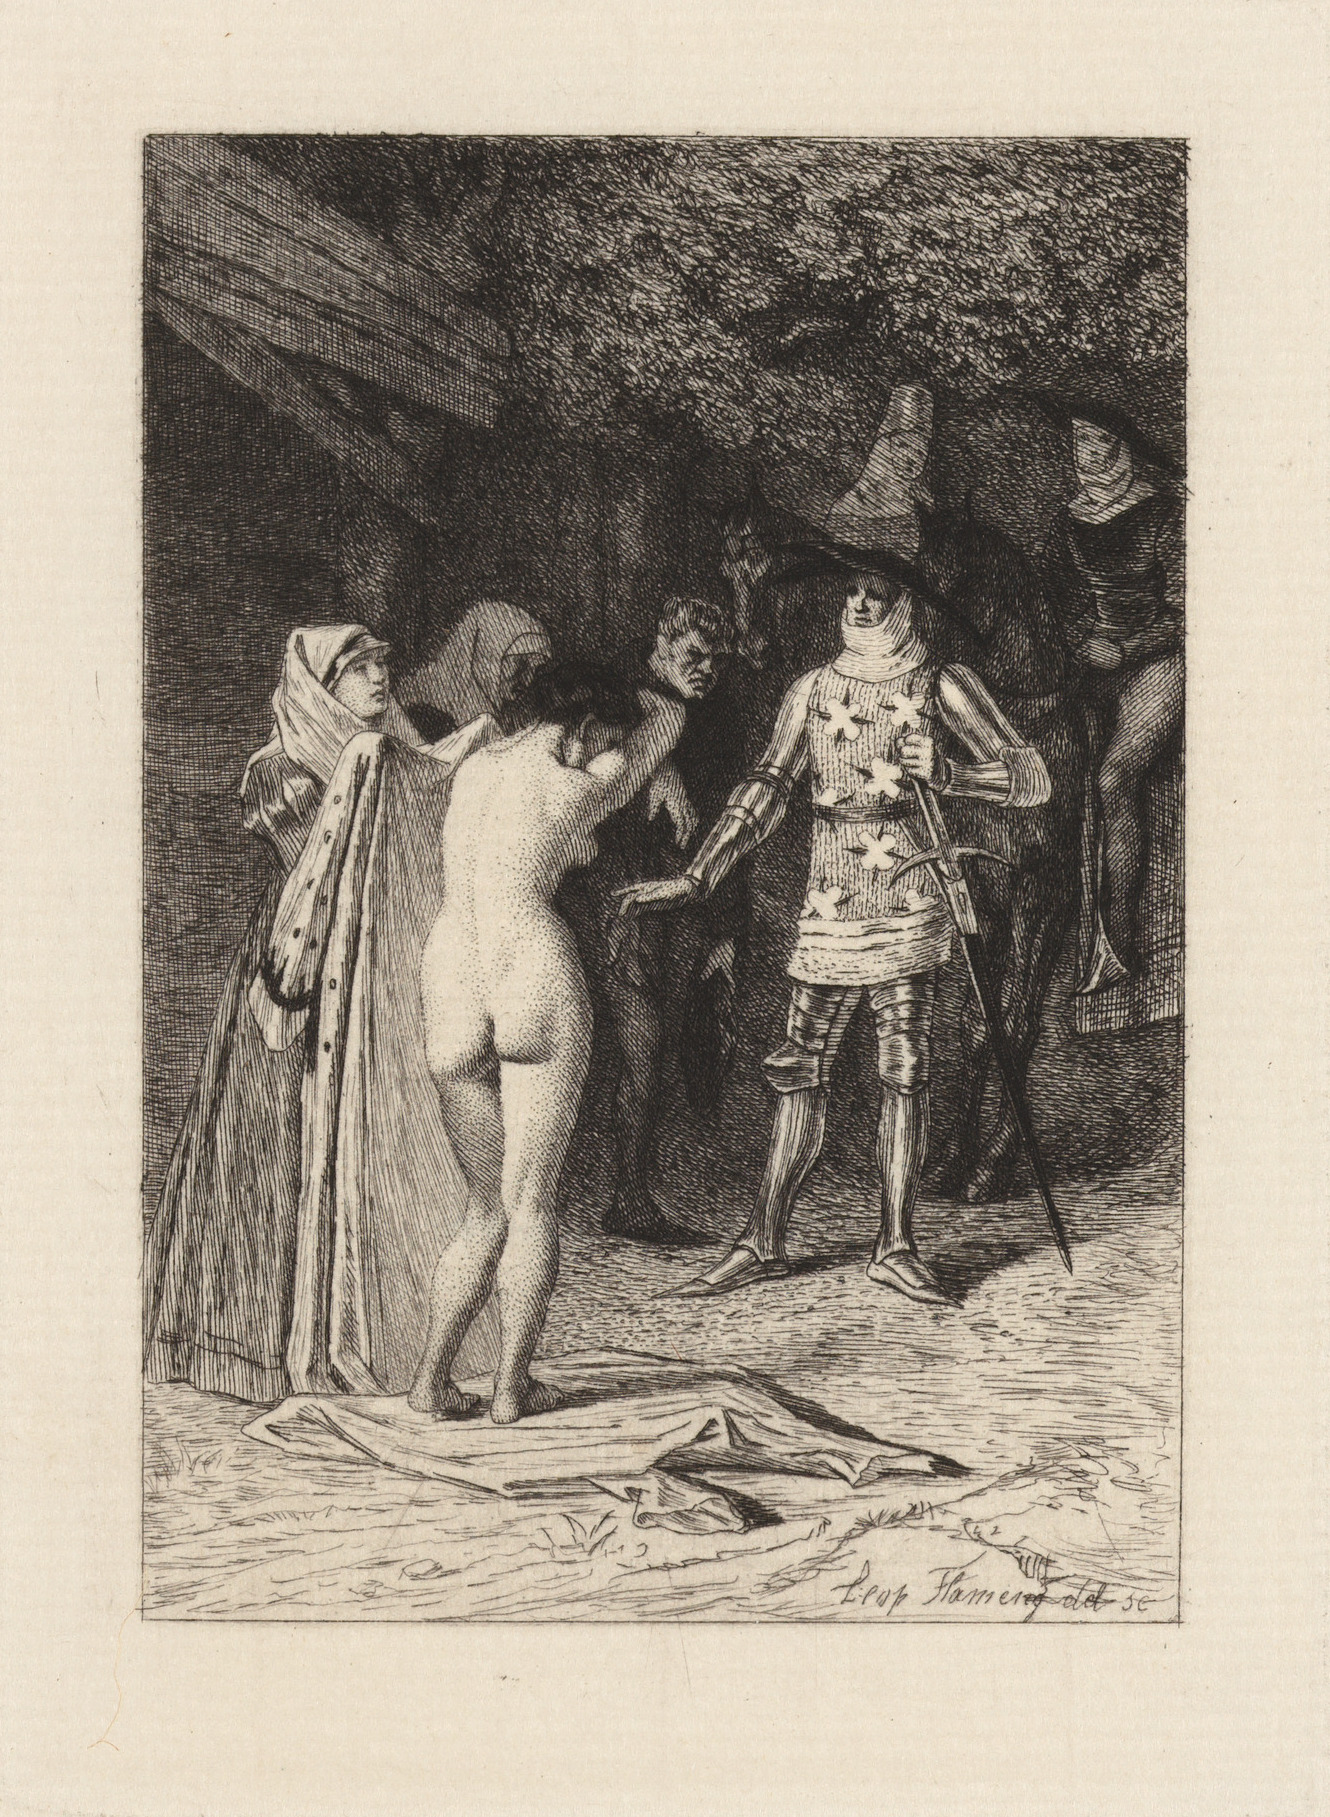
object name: print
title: Grisélidis, plate 10 from "The Decameron"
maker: léopold flameng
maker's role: engraver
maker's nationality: french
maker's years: 1831-1911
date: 1873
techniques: etching